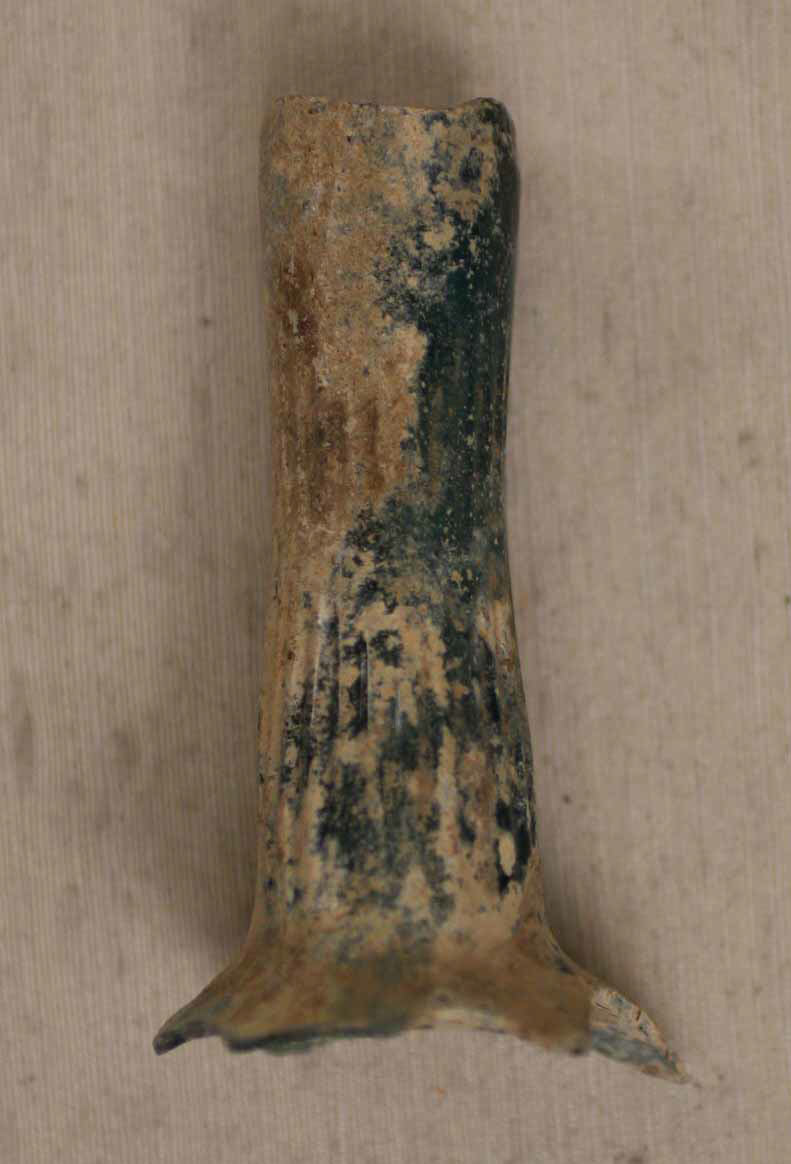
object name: fragment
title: Fragment of a Bottle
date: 701-900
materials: glass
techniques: glassblowing, tooling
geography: iraq